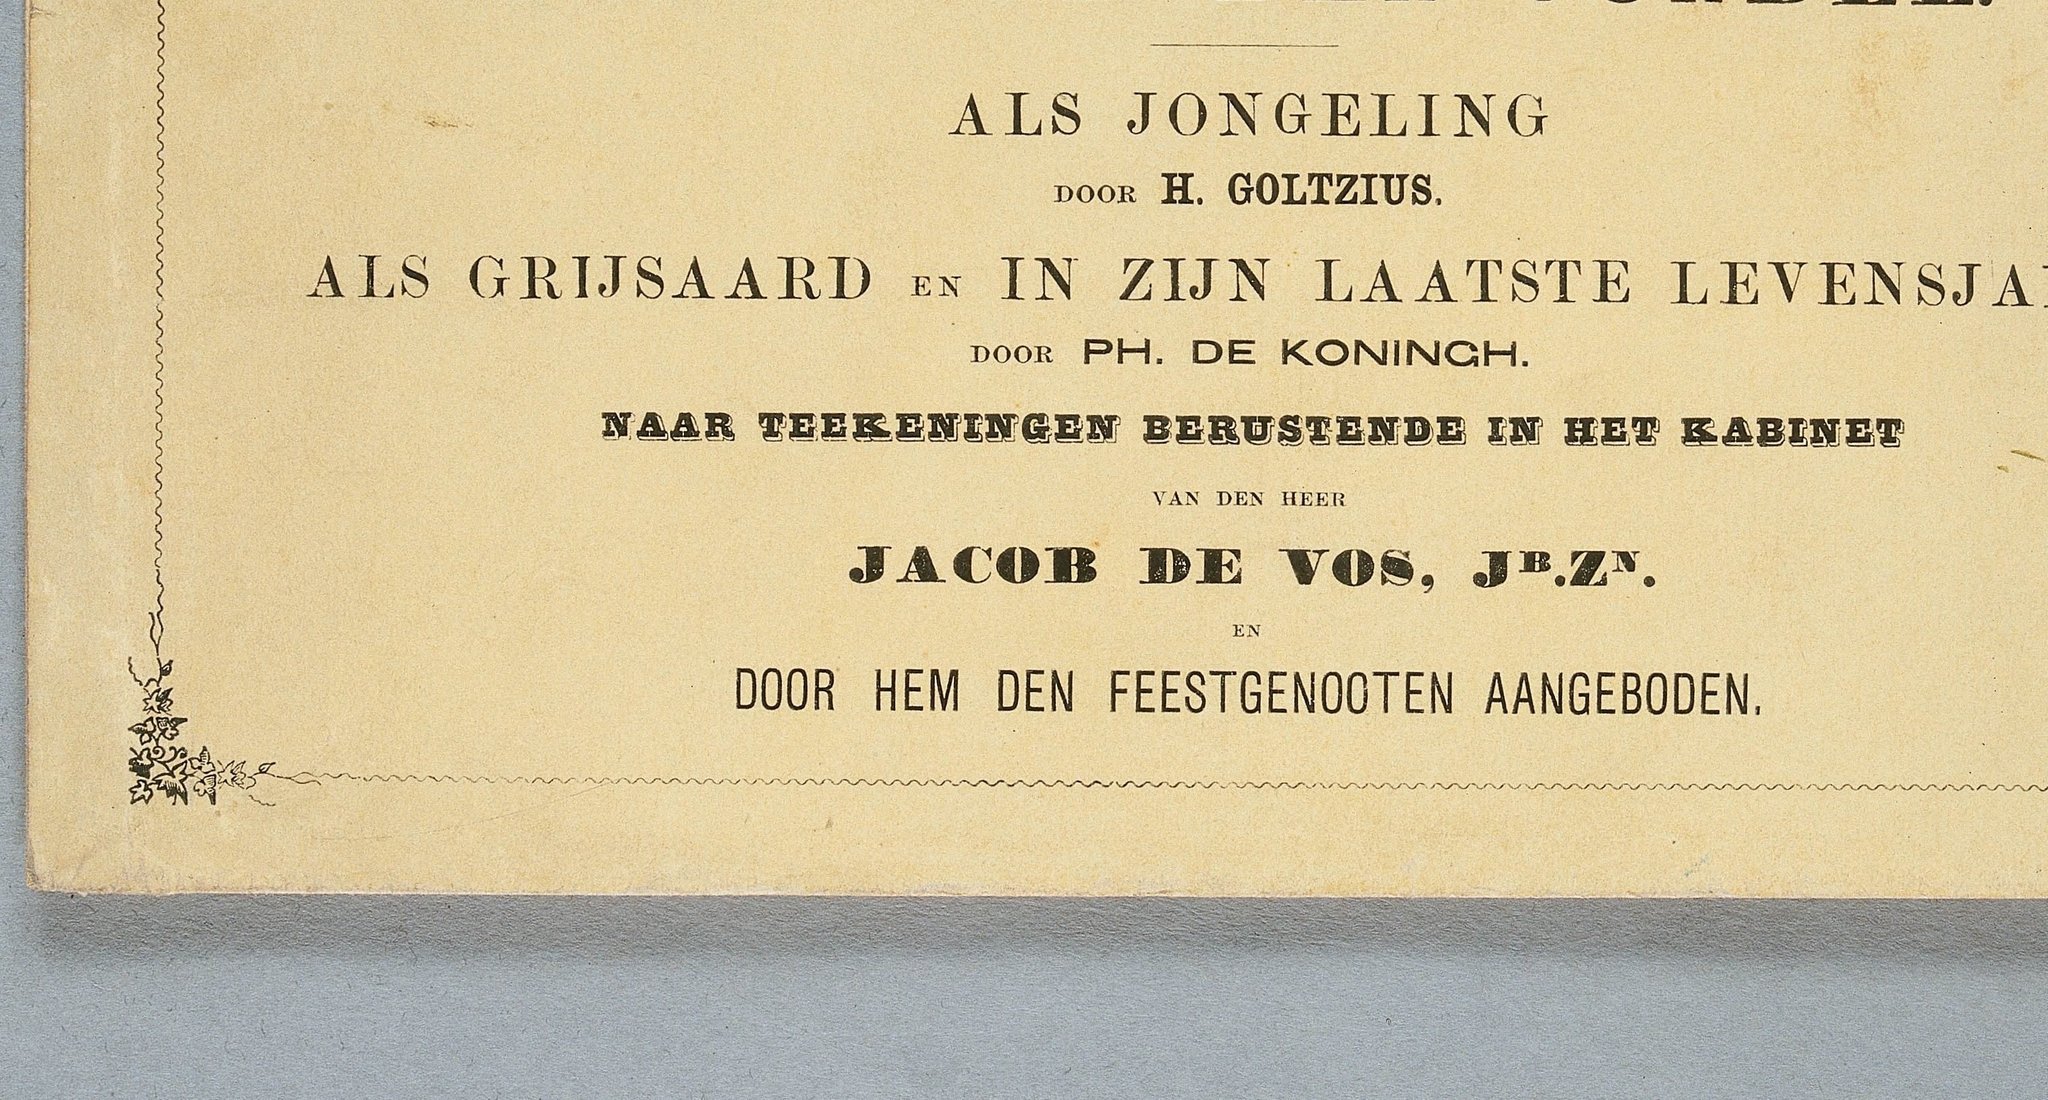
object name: photograph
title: Drie portretten van Joost van den Vondel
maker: franz wilhelm deutmann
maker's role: fotograaf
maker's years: 1809-1895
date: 1867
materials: cardboard, paper, photographic support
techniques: albumen print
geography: amsterdam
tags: amsterdam, joost van den vondel, letter, envelope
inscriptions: stamp: ‘F.W. Deutmann hofphotograaf Amsterdam’, title: ‘DRIE PORTRETTEN / VAN / JOOST VAN DEN VONDEL. / ALS JONGELING / DOOR H. GOLTZIUS. / ALS GRIJSAARD EN IN ZIJN LAATSTE LEVENSJAREN, / DOOR PH. DE KONINGH. / NAAR TEEKENINGEN BERUSTENDE IN HET KABINET / VAN DEN HEER / JACOB DE VOS, JBZN. / EN / DOOR HEM DEN FEESTGENOOTEN AANGEBODEN.’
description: (Reznicek 1961, N 49 d (huidige verblijfplaats onbekend), Gerson 1936, nrs. 276 en 278, collectie Rijksprentenkabinet/Rijksmuseum, inv.nrs. RP-T-1884-A-367 resp. RP-T-1884-A-384).. onzeker: titel suggereert feestelijke gebeurtenis: op 18/10/1867 werd het standbeeld in het (latere) Vondelpark onthuld